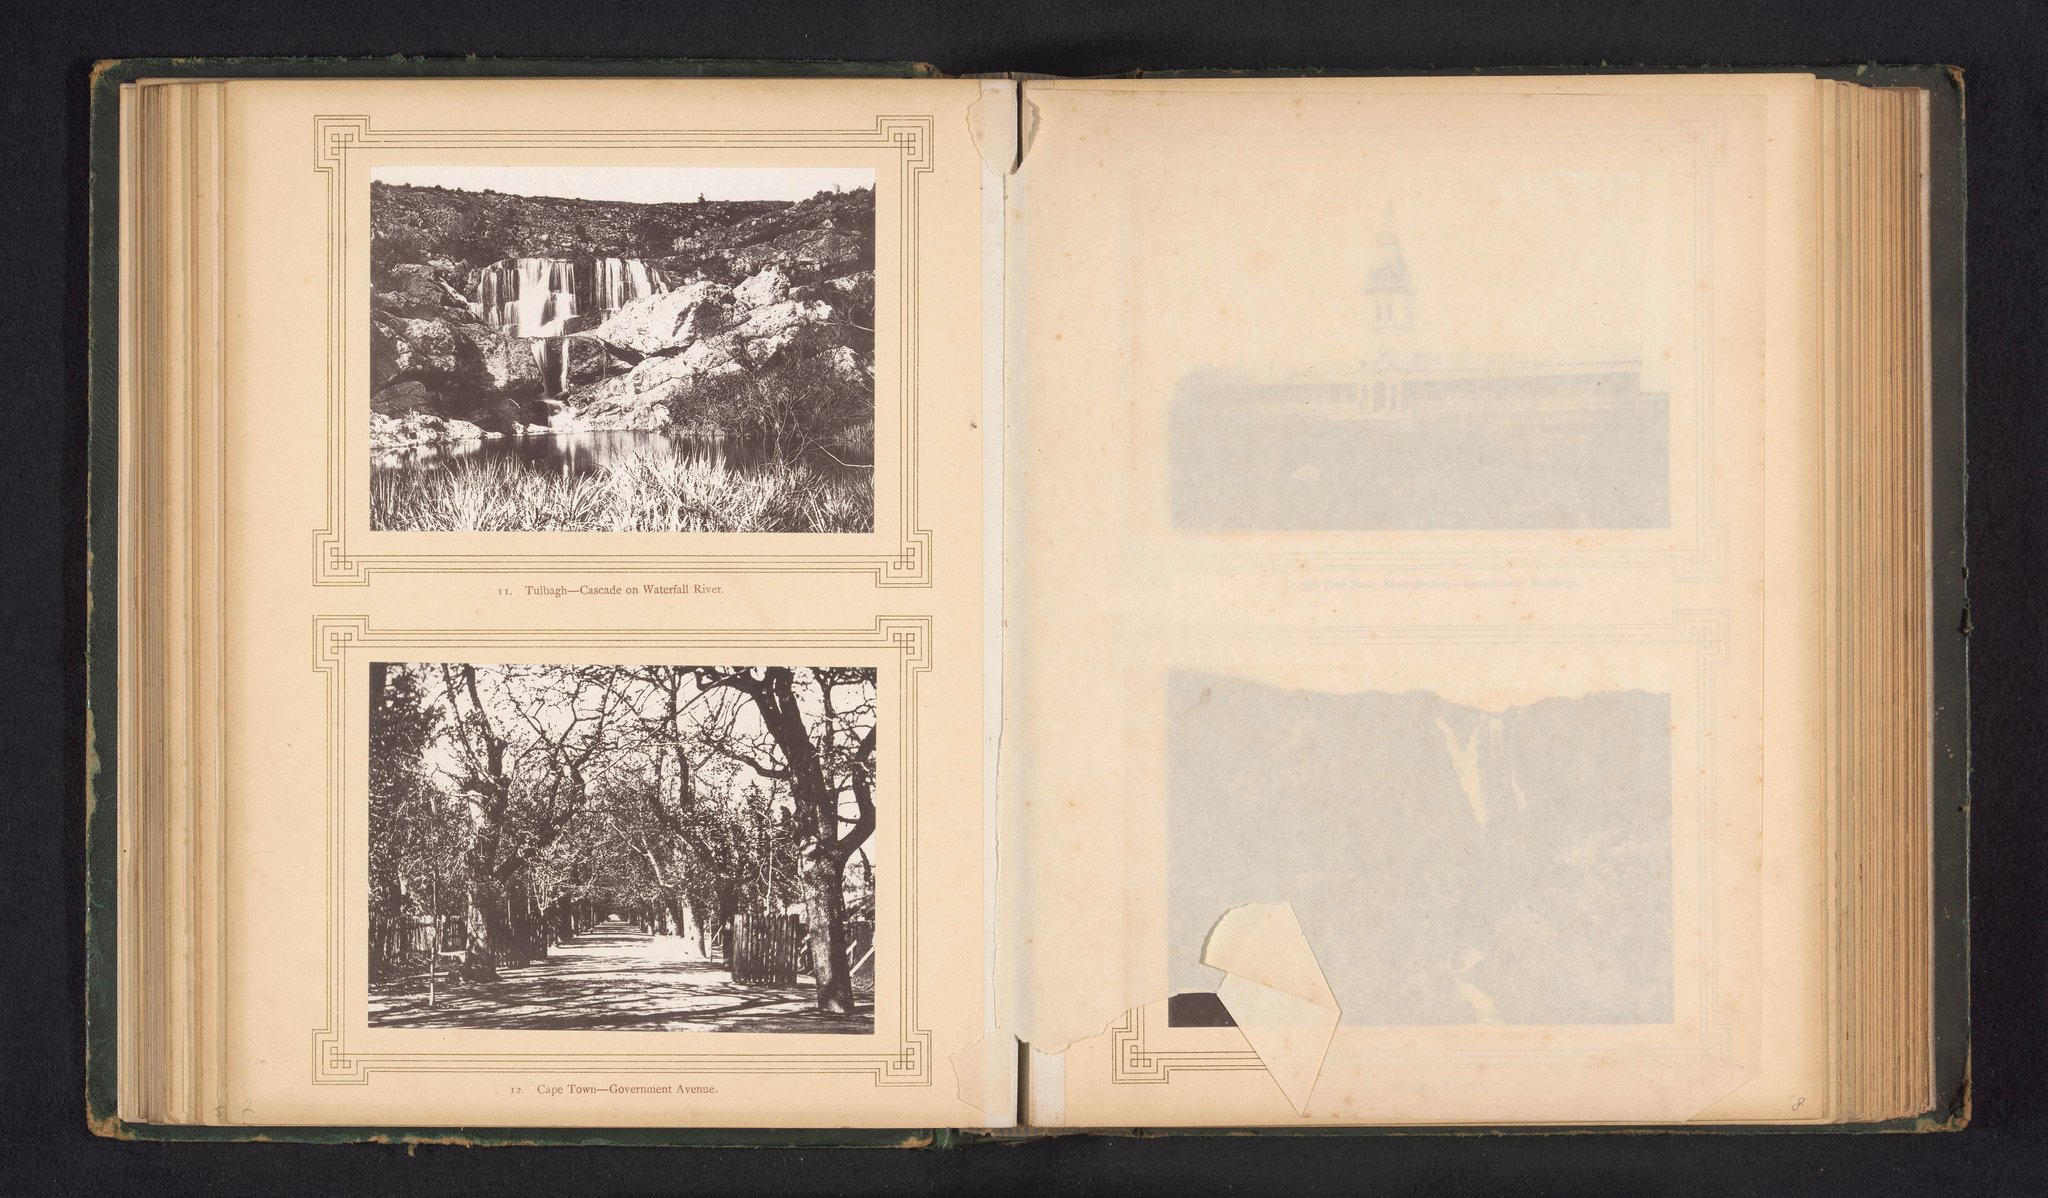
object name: photomechanical print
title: Tulbagh-Cascade on waterfall river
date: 1870-1880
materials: paper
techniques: photograph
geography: south africa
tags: waterfall, avenue, boulevard, promenade, esplanade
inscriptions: number: ‘11. 12.’, inscription: ‘SA’